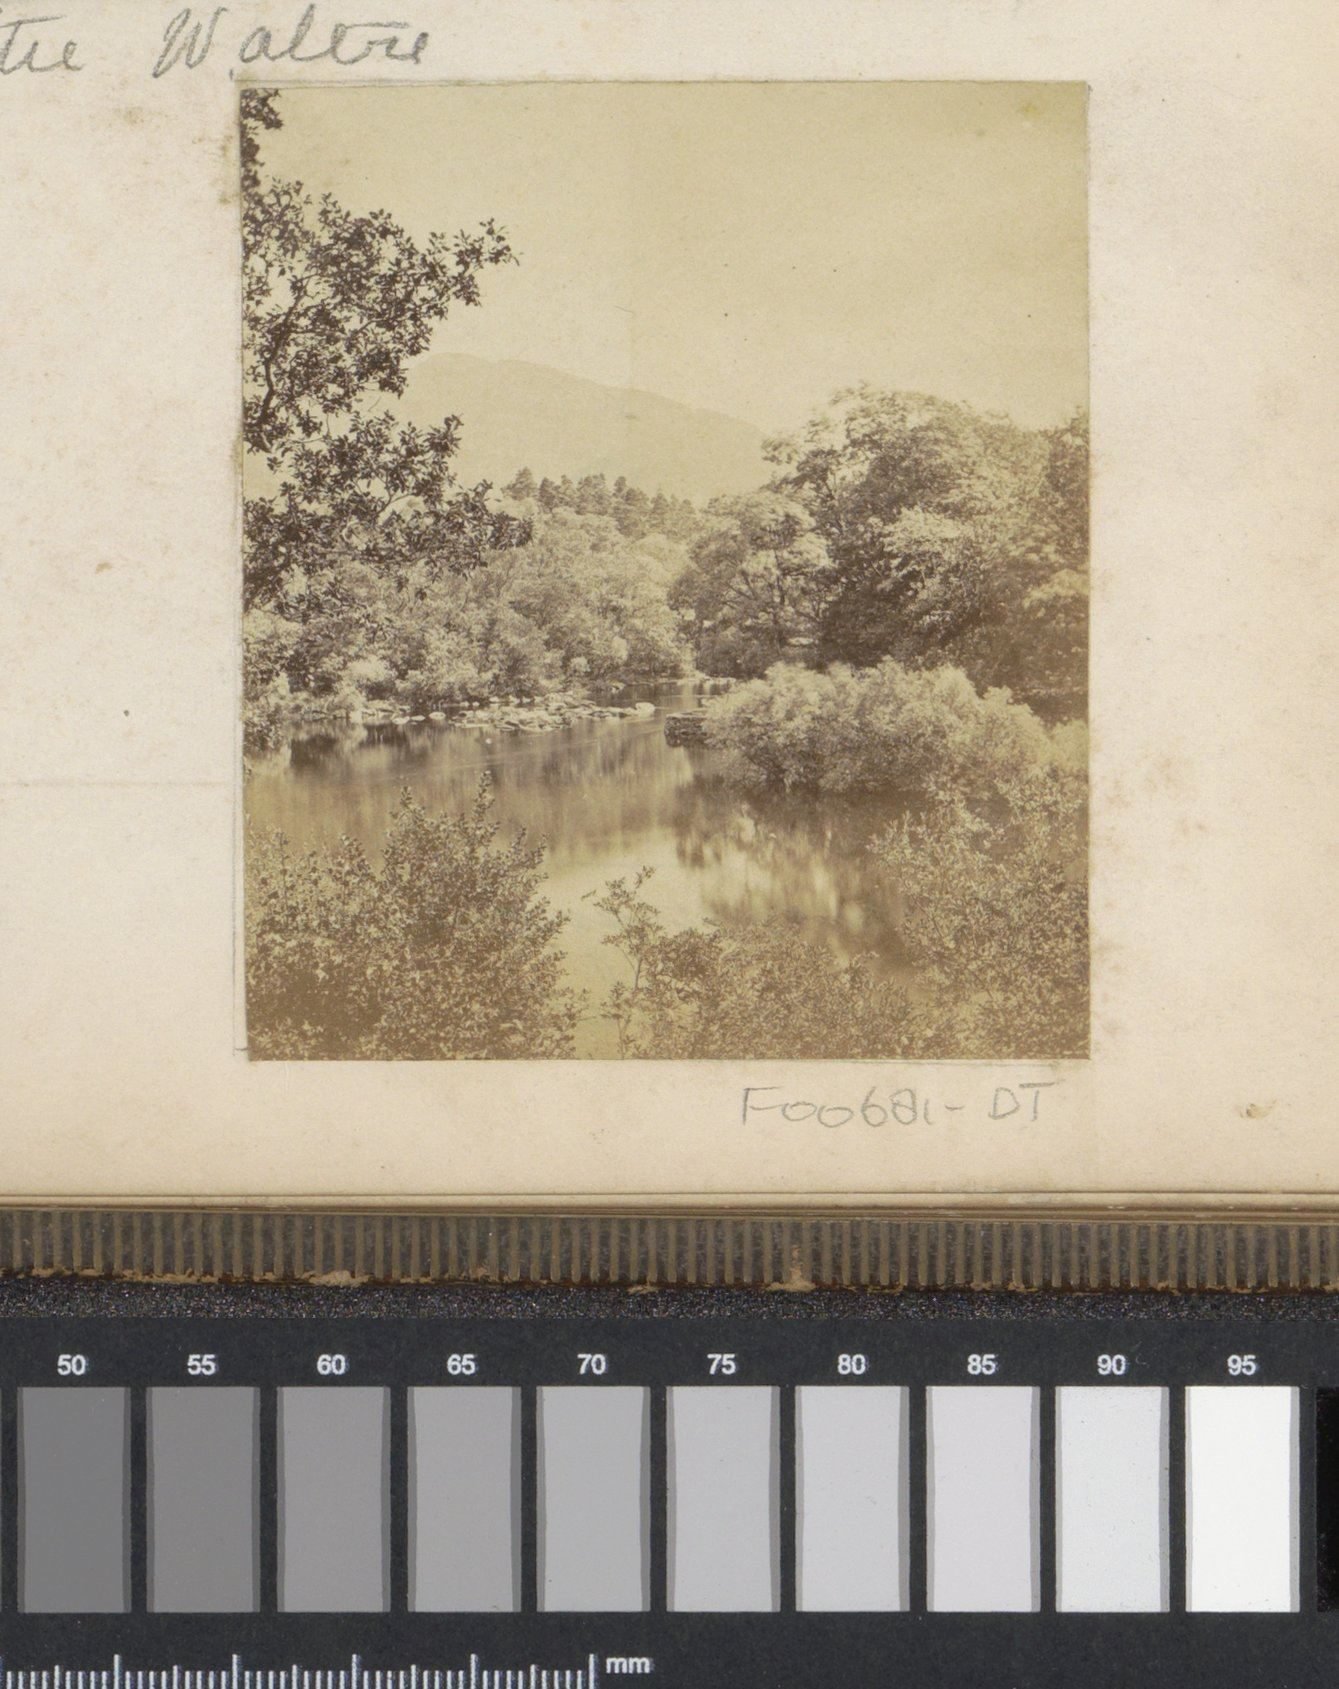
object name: photograph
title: Rivierlandschap, vermoedelijk in Engeland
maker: Anonymous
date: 1850-1870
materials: paper, photographic support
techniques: albumen print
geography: england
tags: landscapes with waters, waterscapes, seascapes (in the temperate zone) (+ landscape with figures, staffage), england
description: Onderdeel van Album met foto's van bezienswaardigheden en landschappen in Engeland en van kunst.